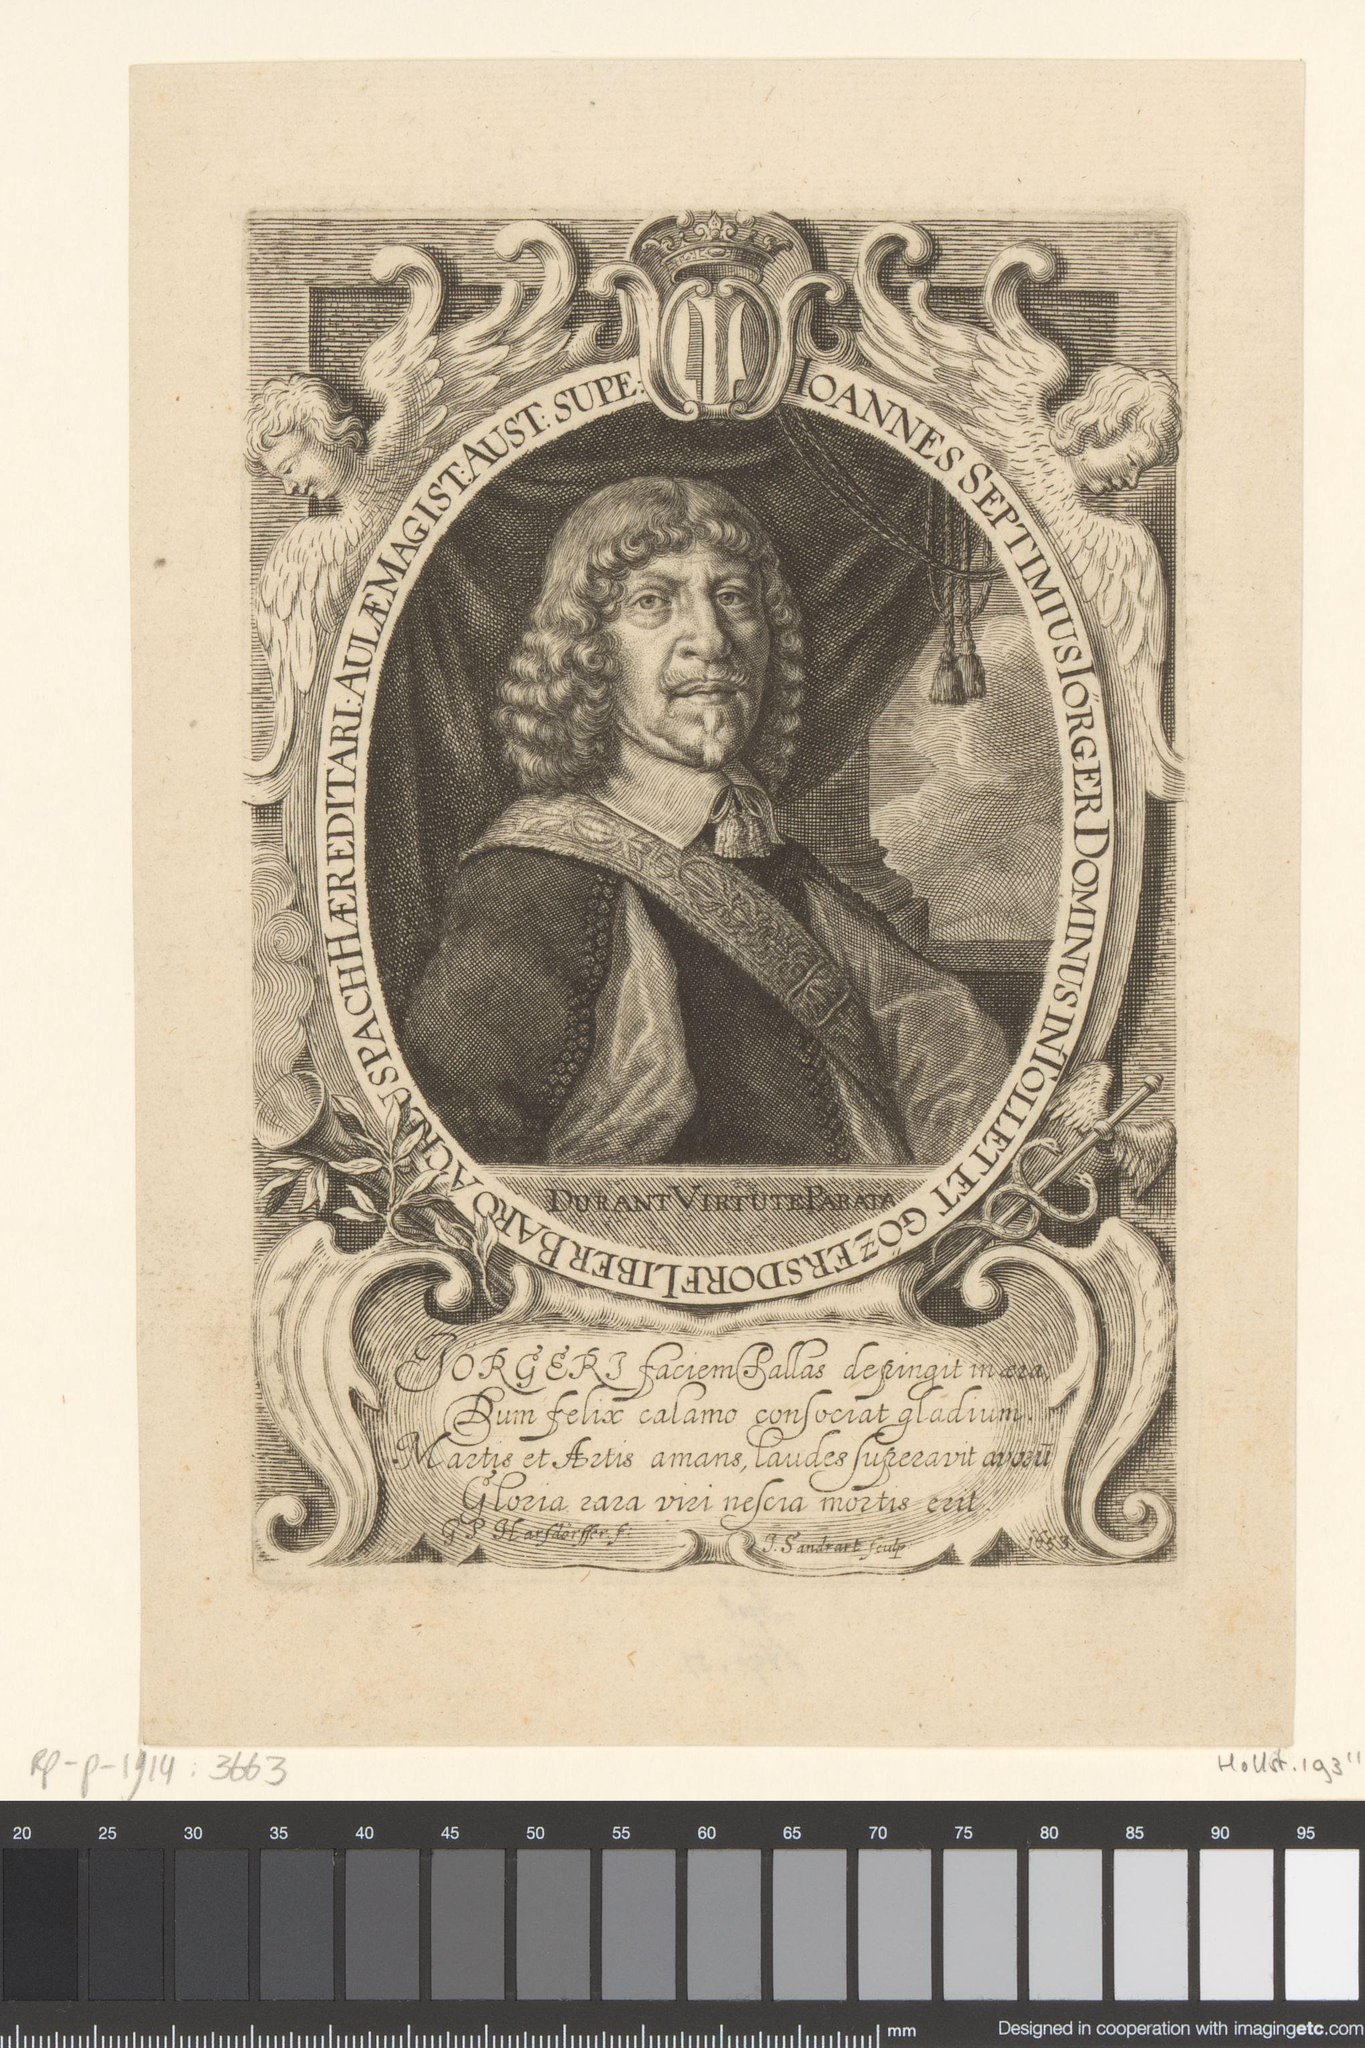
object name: print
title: Portret van Johann Septimius Jörger von Tollet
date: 1653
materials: paper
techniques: engraving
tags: print maker, historical persons, armorial bearing, heraldry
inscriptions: collector's mark: Lugt 2228